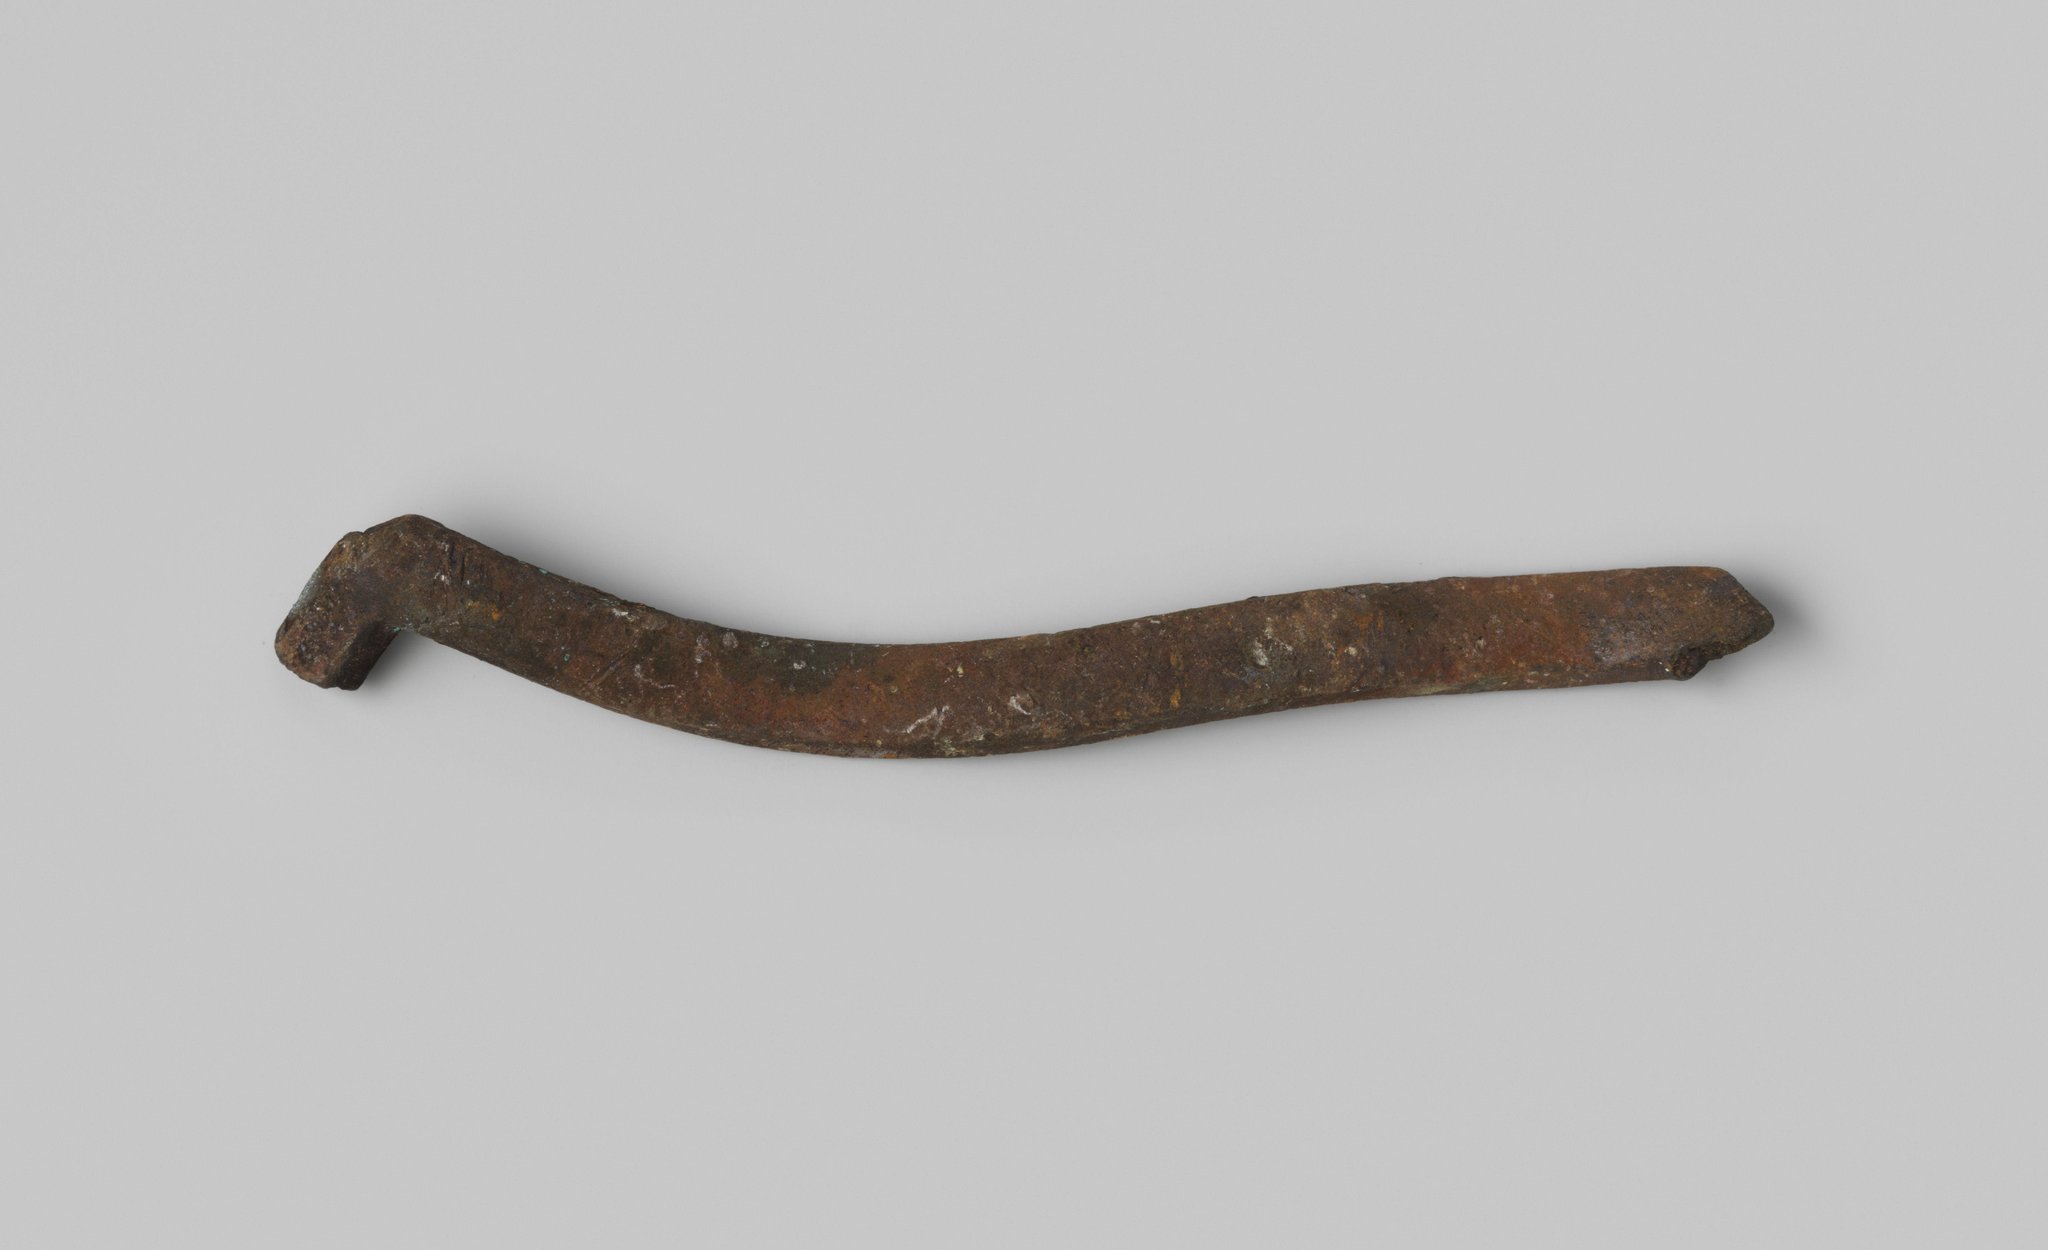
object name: belt buckle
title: Fragment riemgesp uit het wrak van de Oost-Indiëvaarder Hollandia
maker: Anonymous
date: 1700-1743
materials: copper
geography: netherlands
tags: verenigde oostindische compagnie, hollandia (schip), annet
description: Rectangular, fragm of ring, id. NG 1980-27H2852, belt buckle.